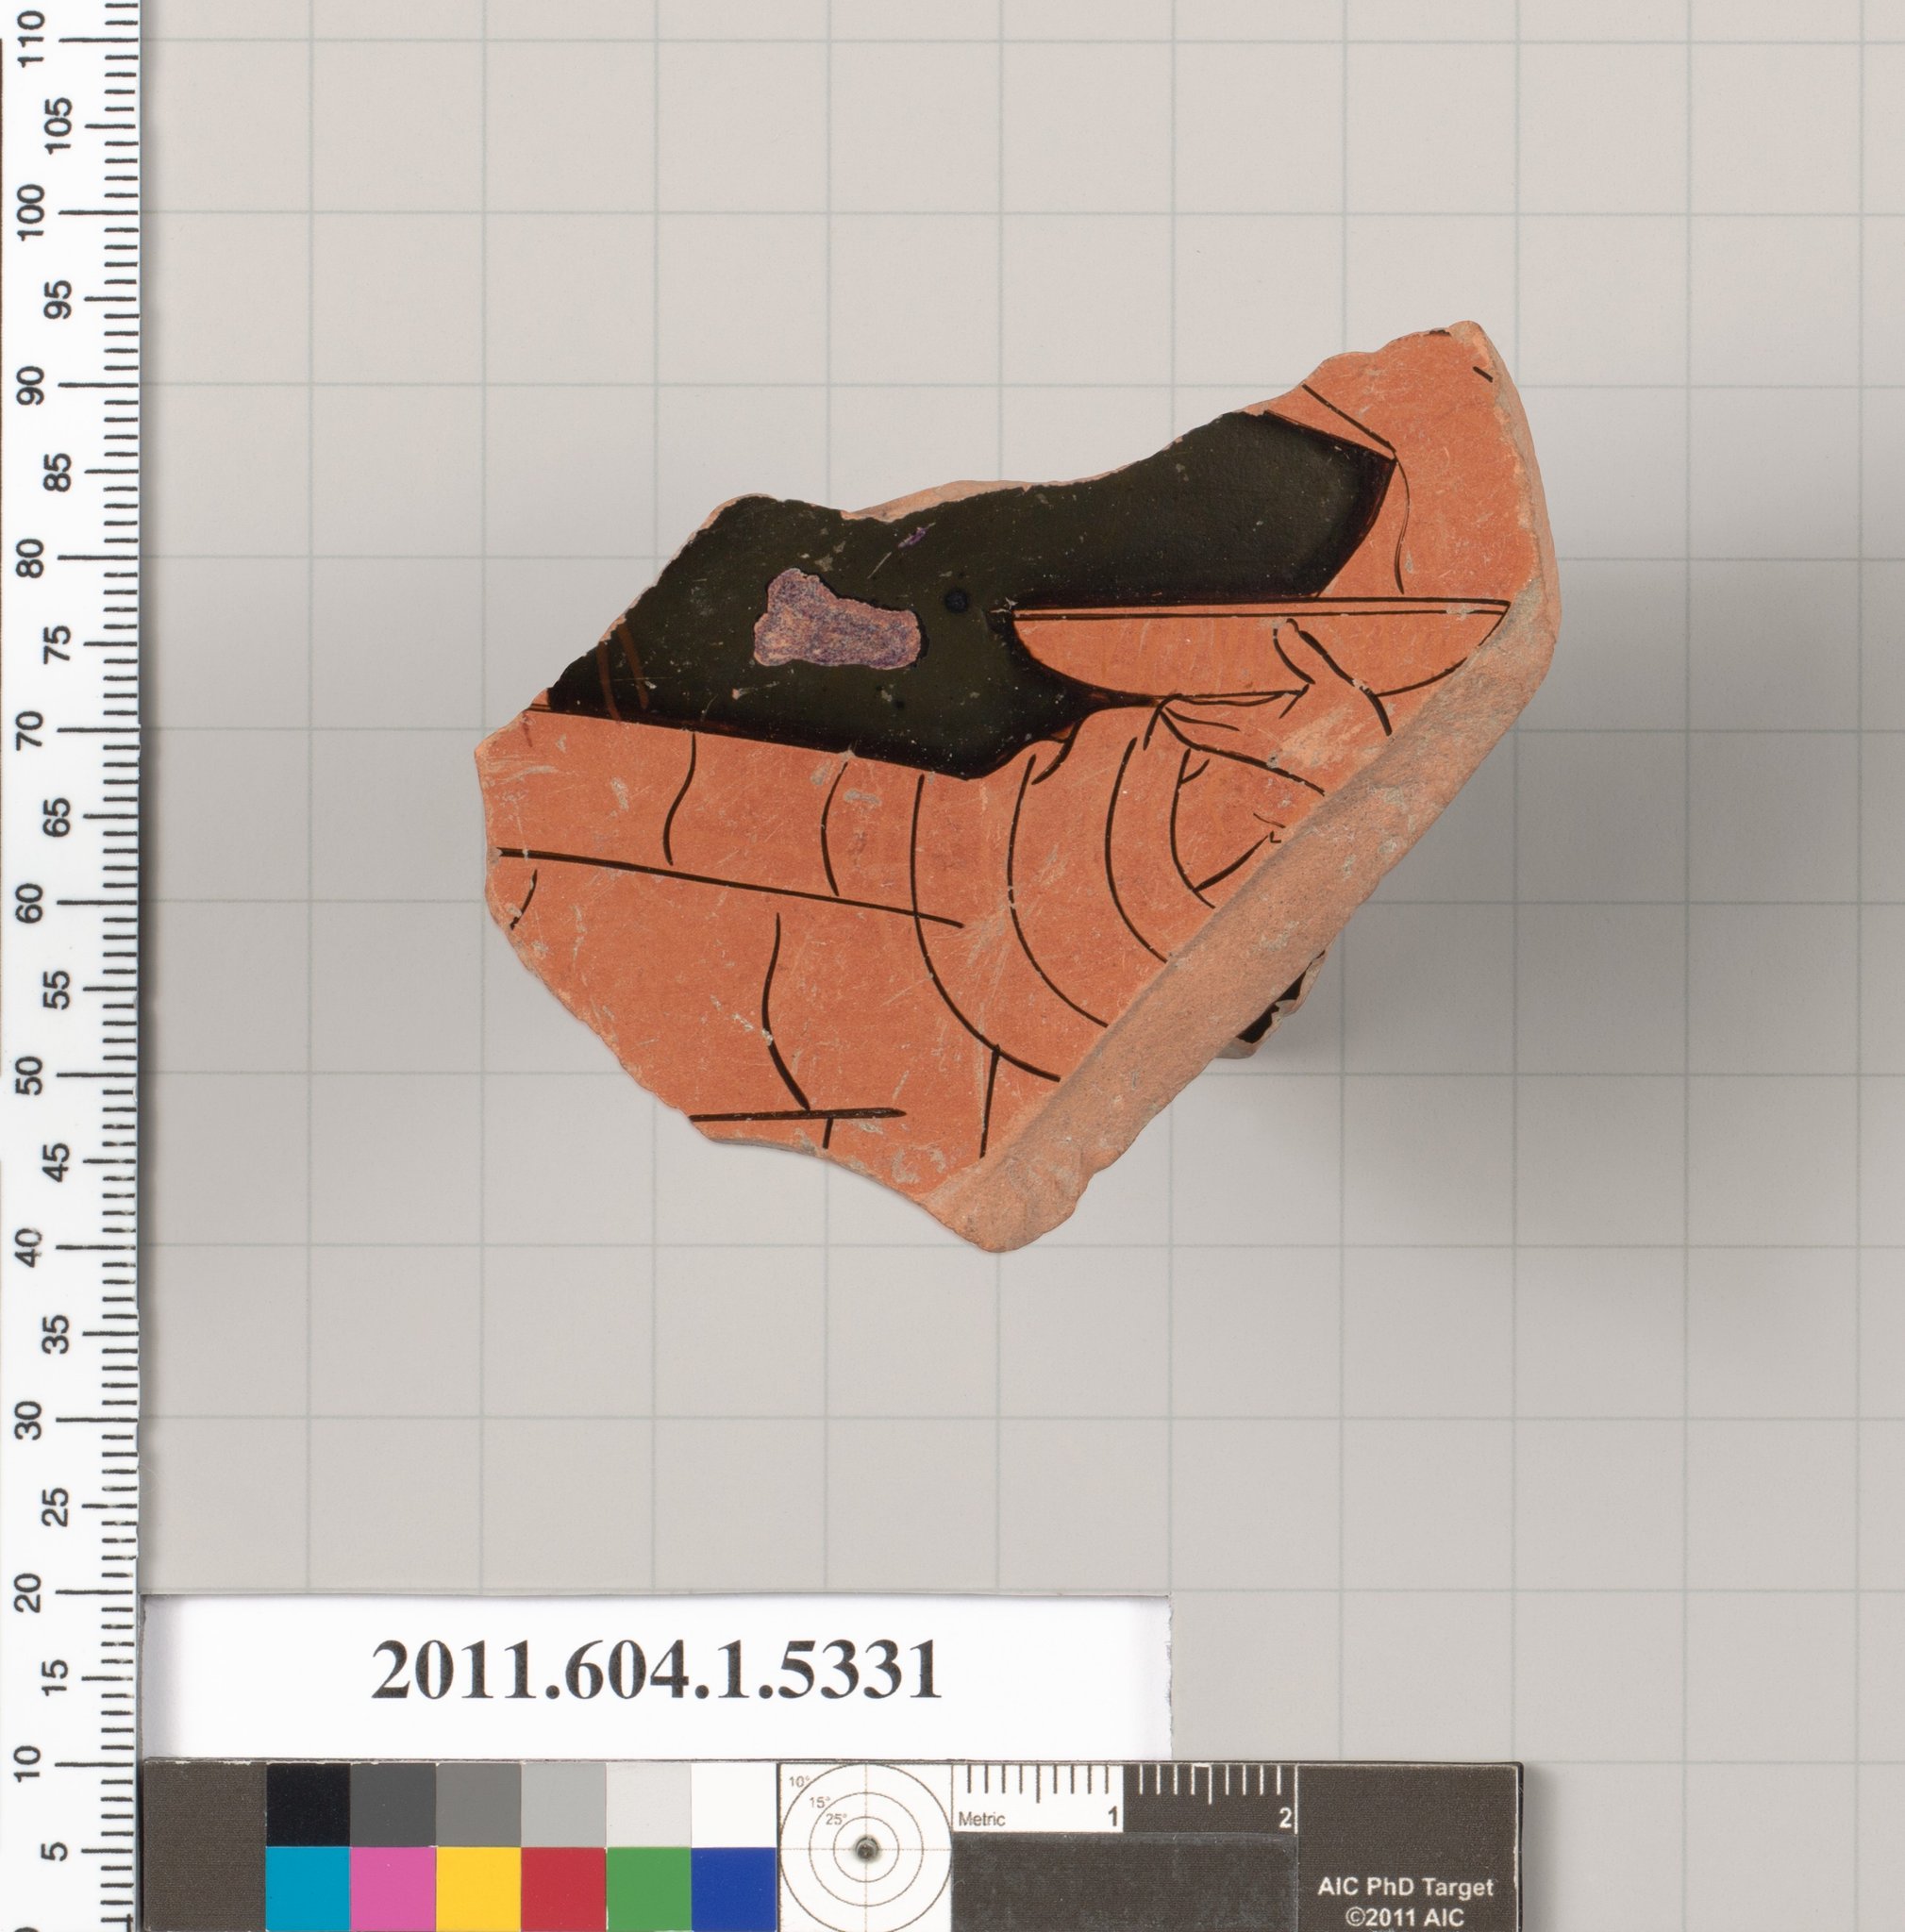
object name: kylix fragment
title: Terracotta fragment of a kylix (drinking cup)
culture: greek, attic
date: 500-480 BCE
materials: terracotta